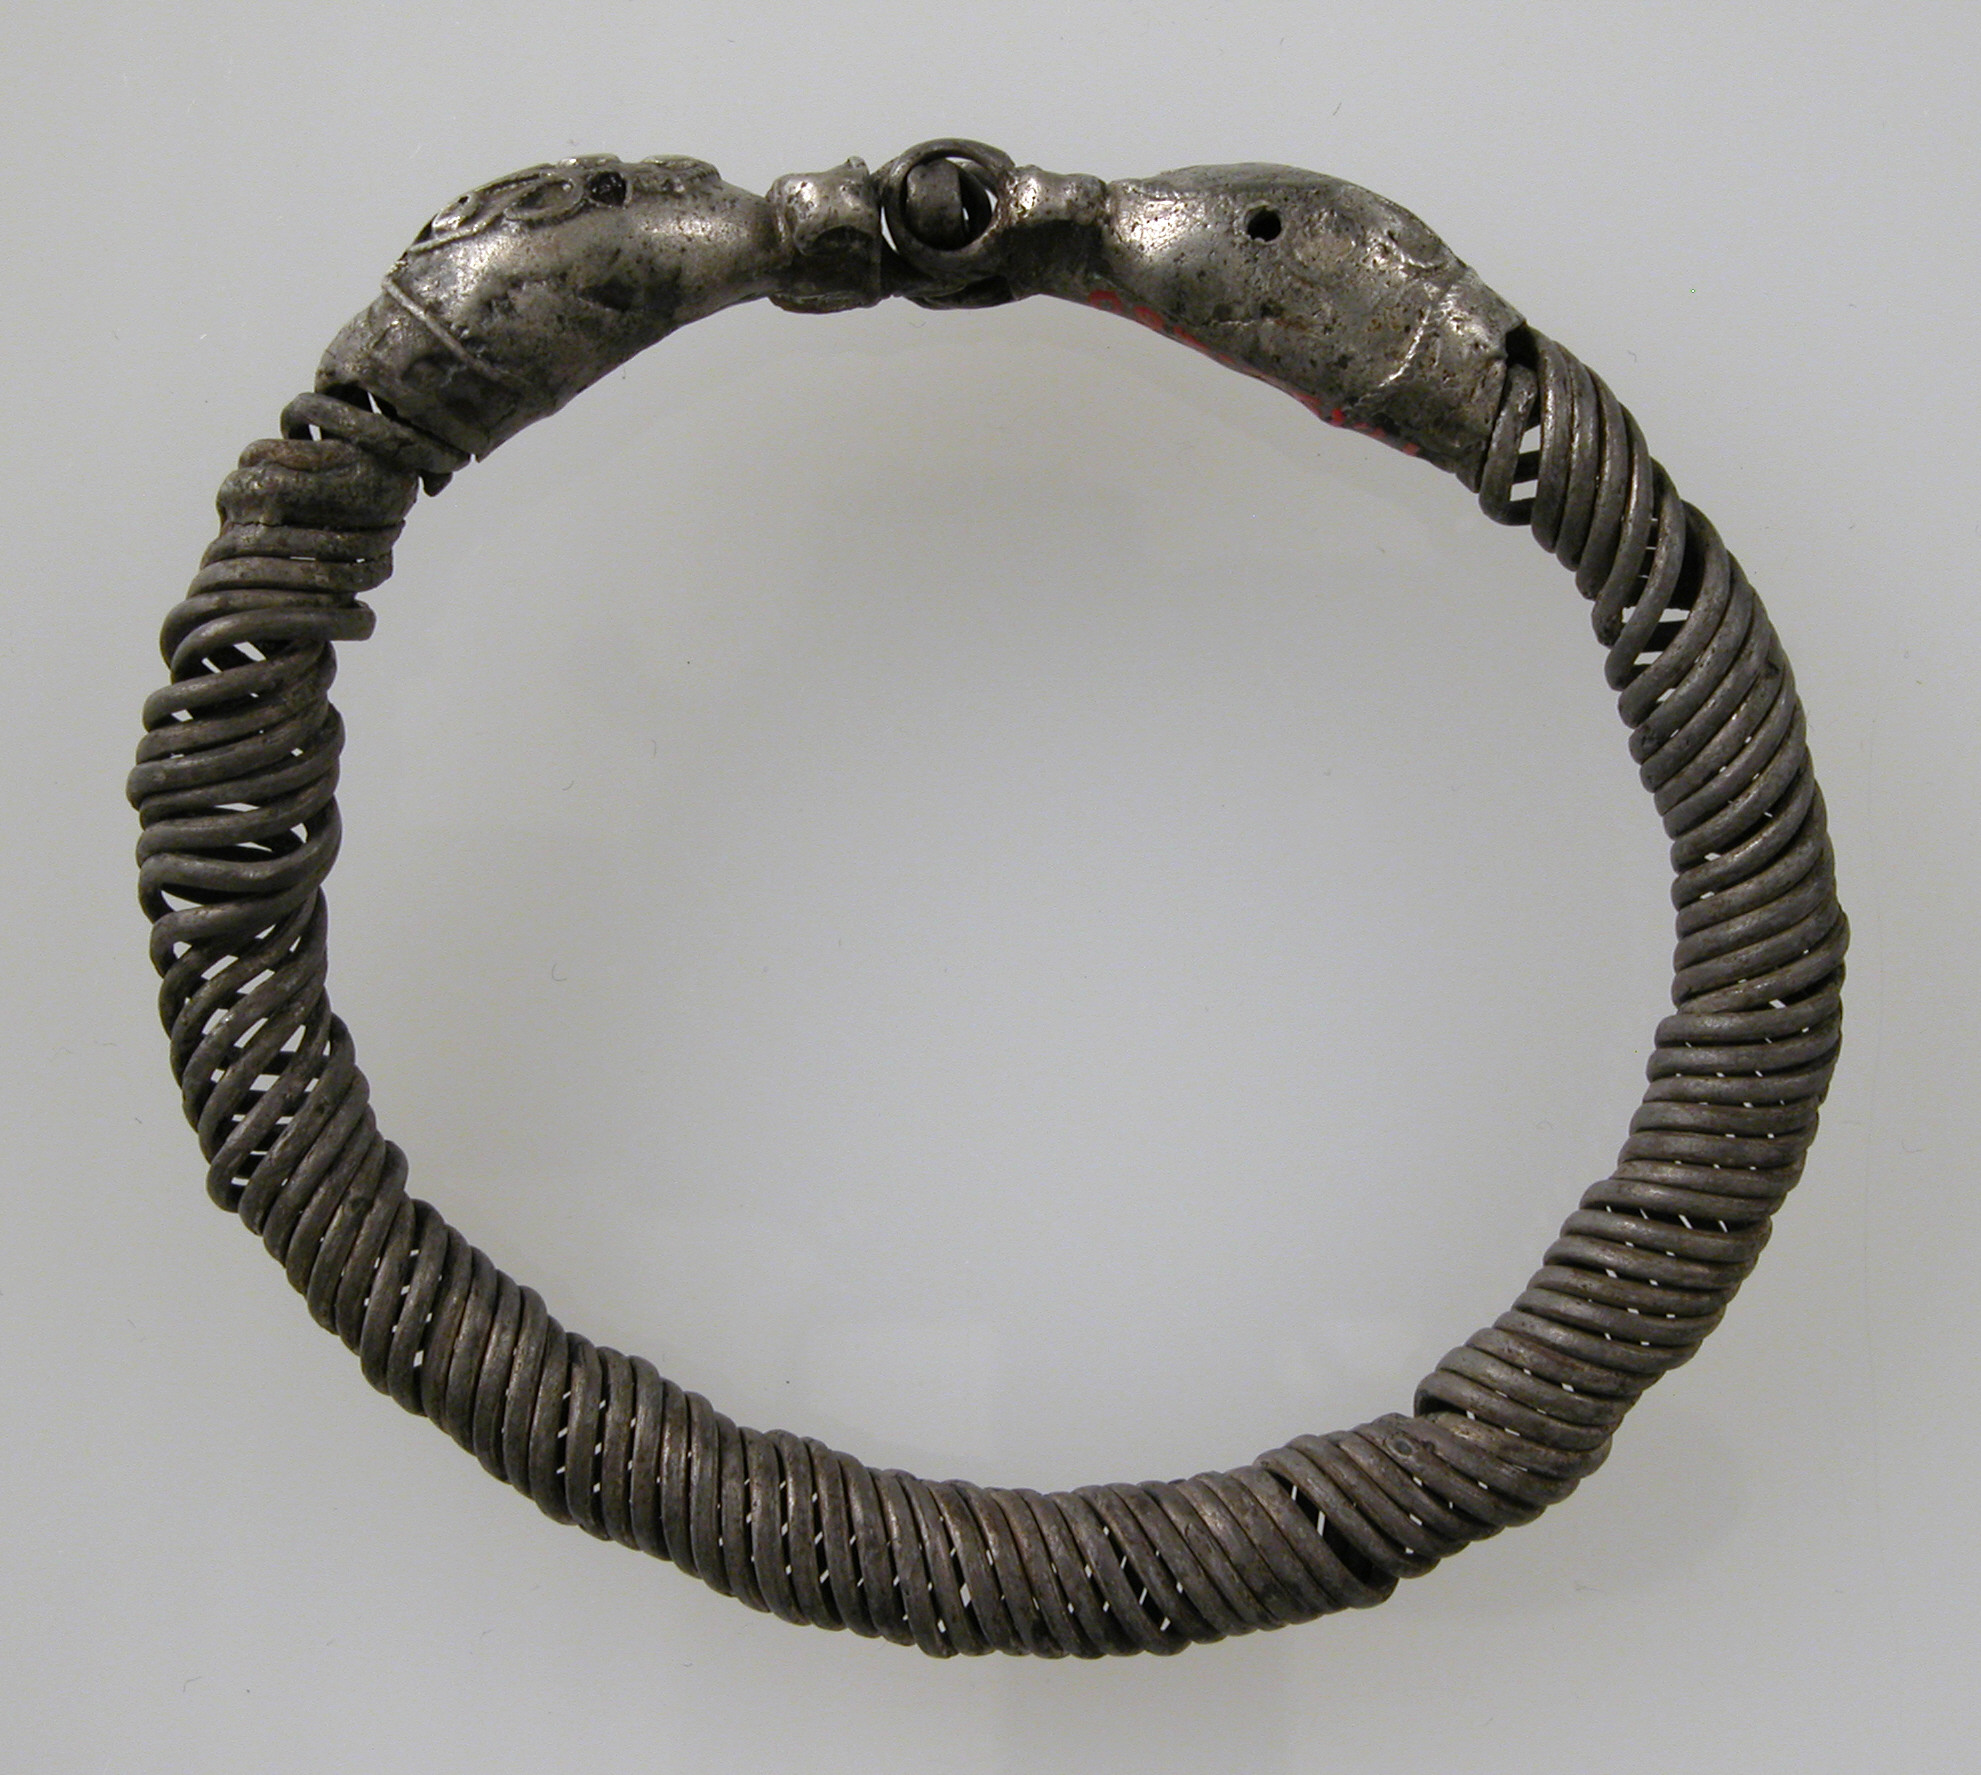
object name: bracelet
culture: roman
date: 201-500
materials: gemstone, glass, paste, silver